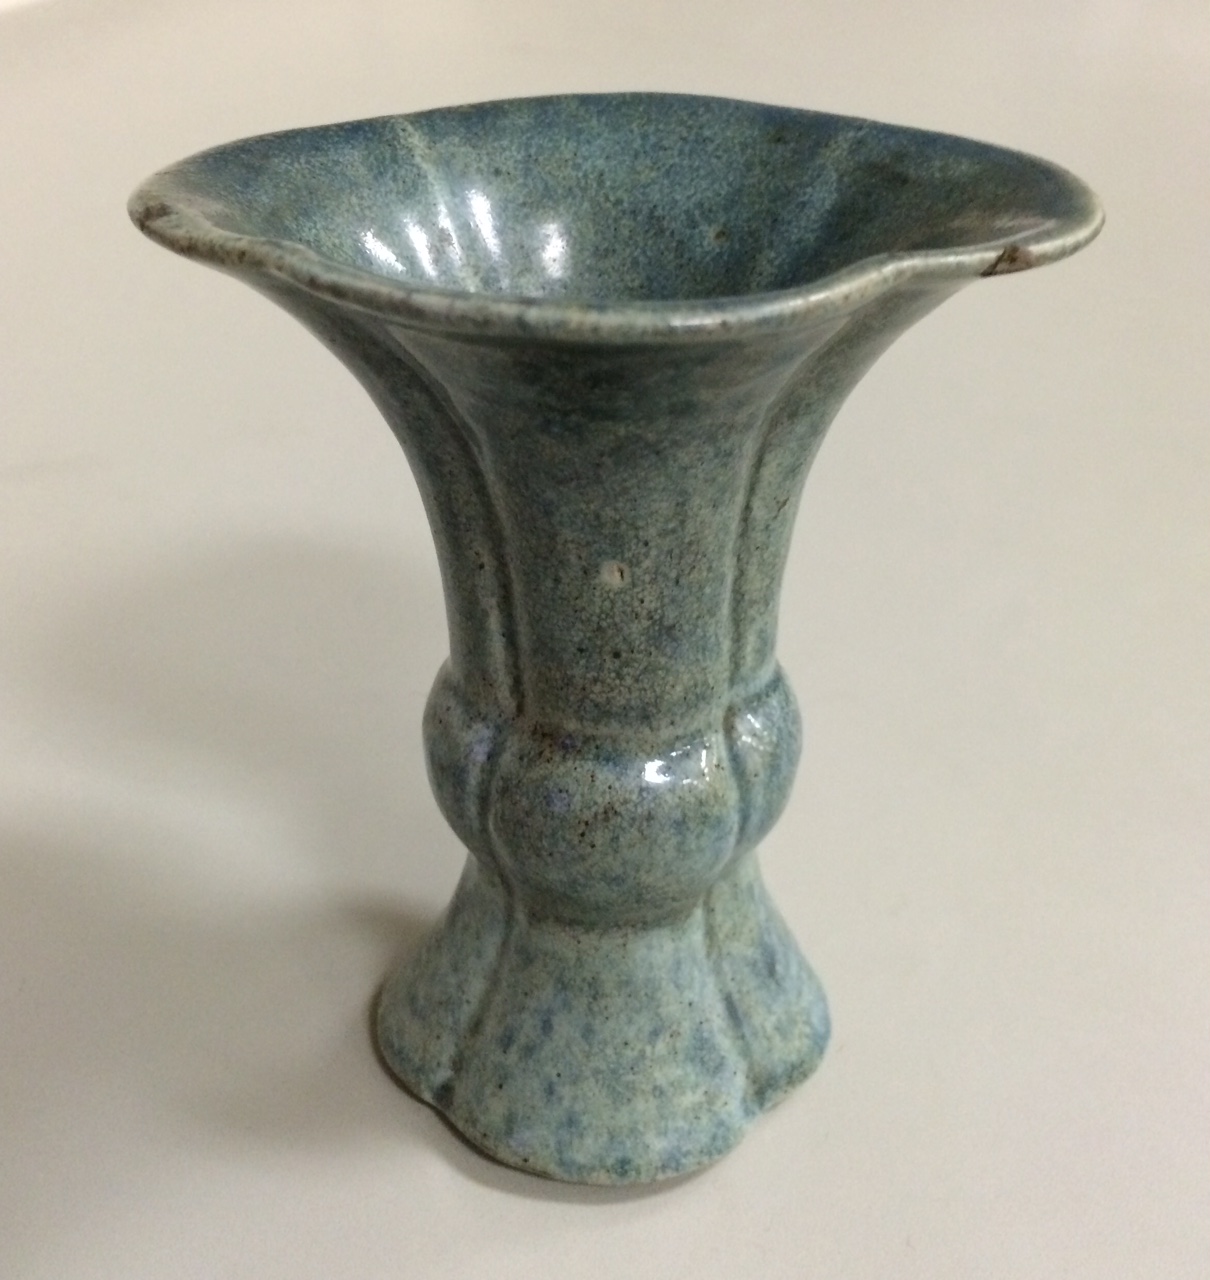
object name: vase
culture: chinese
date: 1736-1795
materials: glaze, porcelain